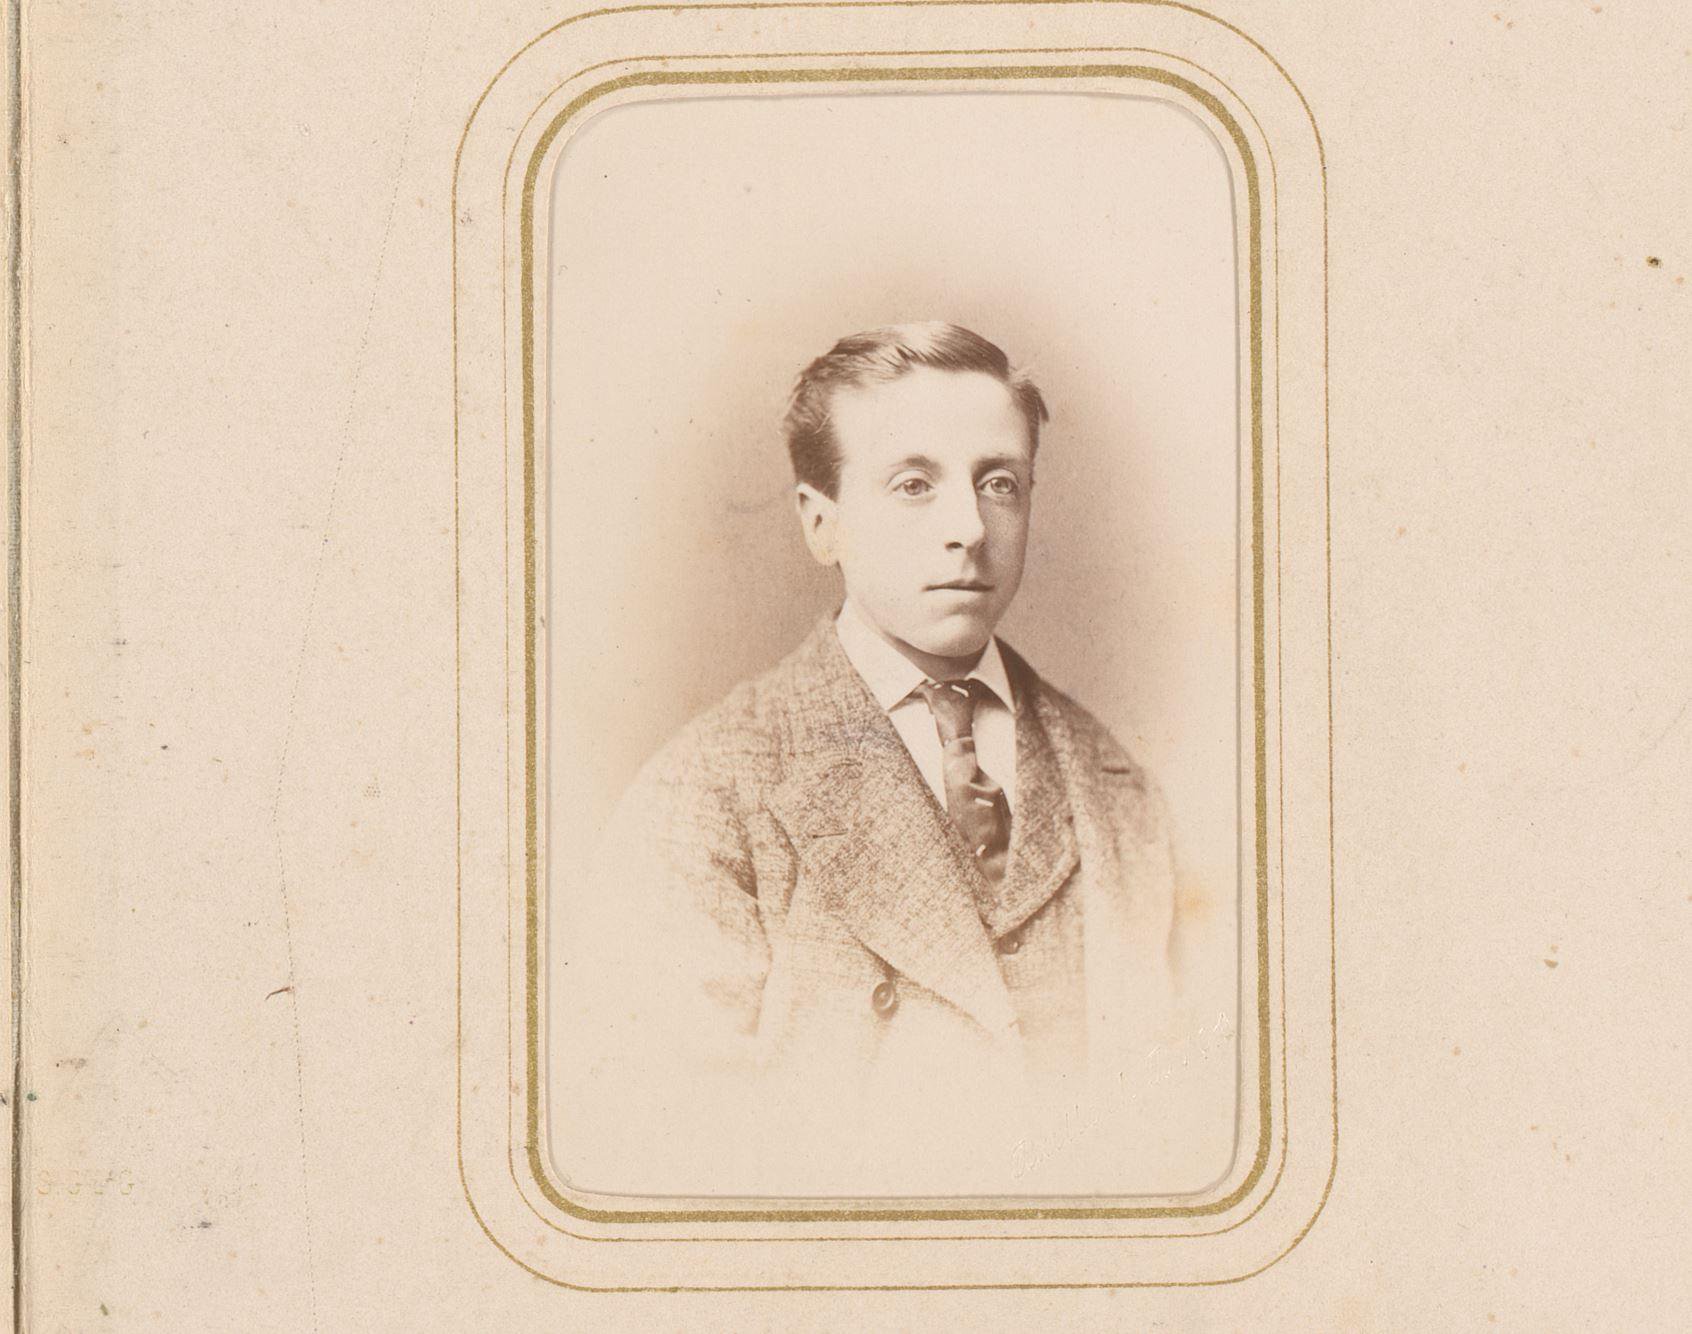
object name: photograph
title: Portret van een jonge man met stropdas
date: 1876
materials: cardboard, photographic support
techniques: albumen print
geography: leamington spa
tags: historical persons, youth, adolescent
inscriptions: date: ‘1876’, date: ‘1876’, inscription: ‘Under Royal Patronage/ BULLOCK BROTHERS/ 20, Lower Parade,/ Royal Leamington./ MEDAL/ OF THE ROYAL POLYTECHNIC SOCIETY CORNWALL 1866./ Honourable Mention/ of the Dublin International Exhibition./ INVENTORS AND PATENTEES OF/ LITHO PHOTOGRAPHY./ Messrs Bullock's Portraits bear the/ palm from all./ Times. notice./ NEGATIVES KEPT./ COPIES ALWAYS TO BE HAD.’